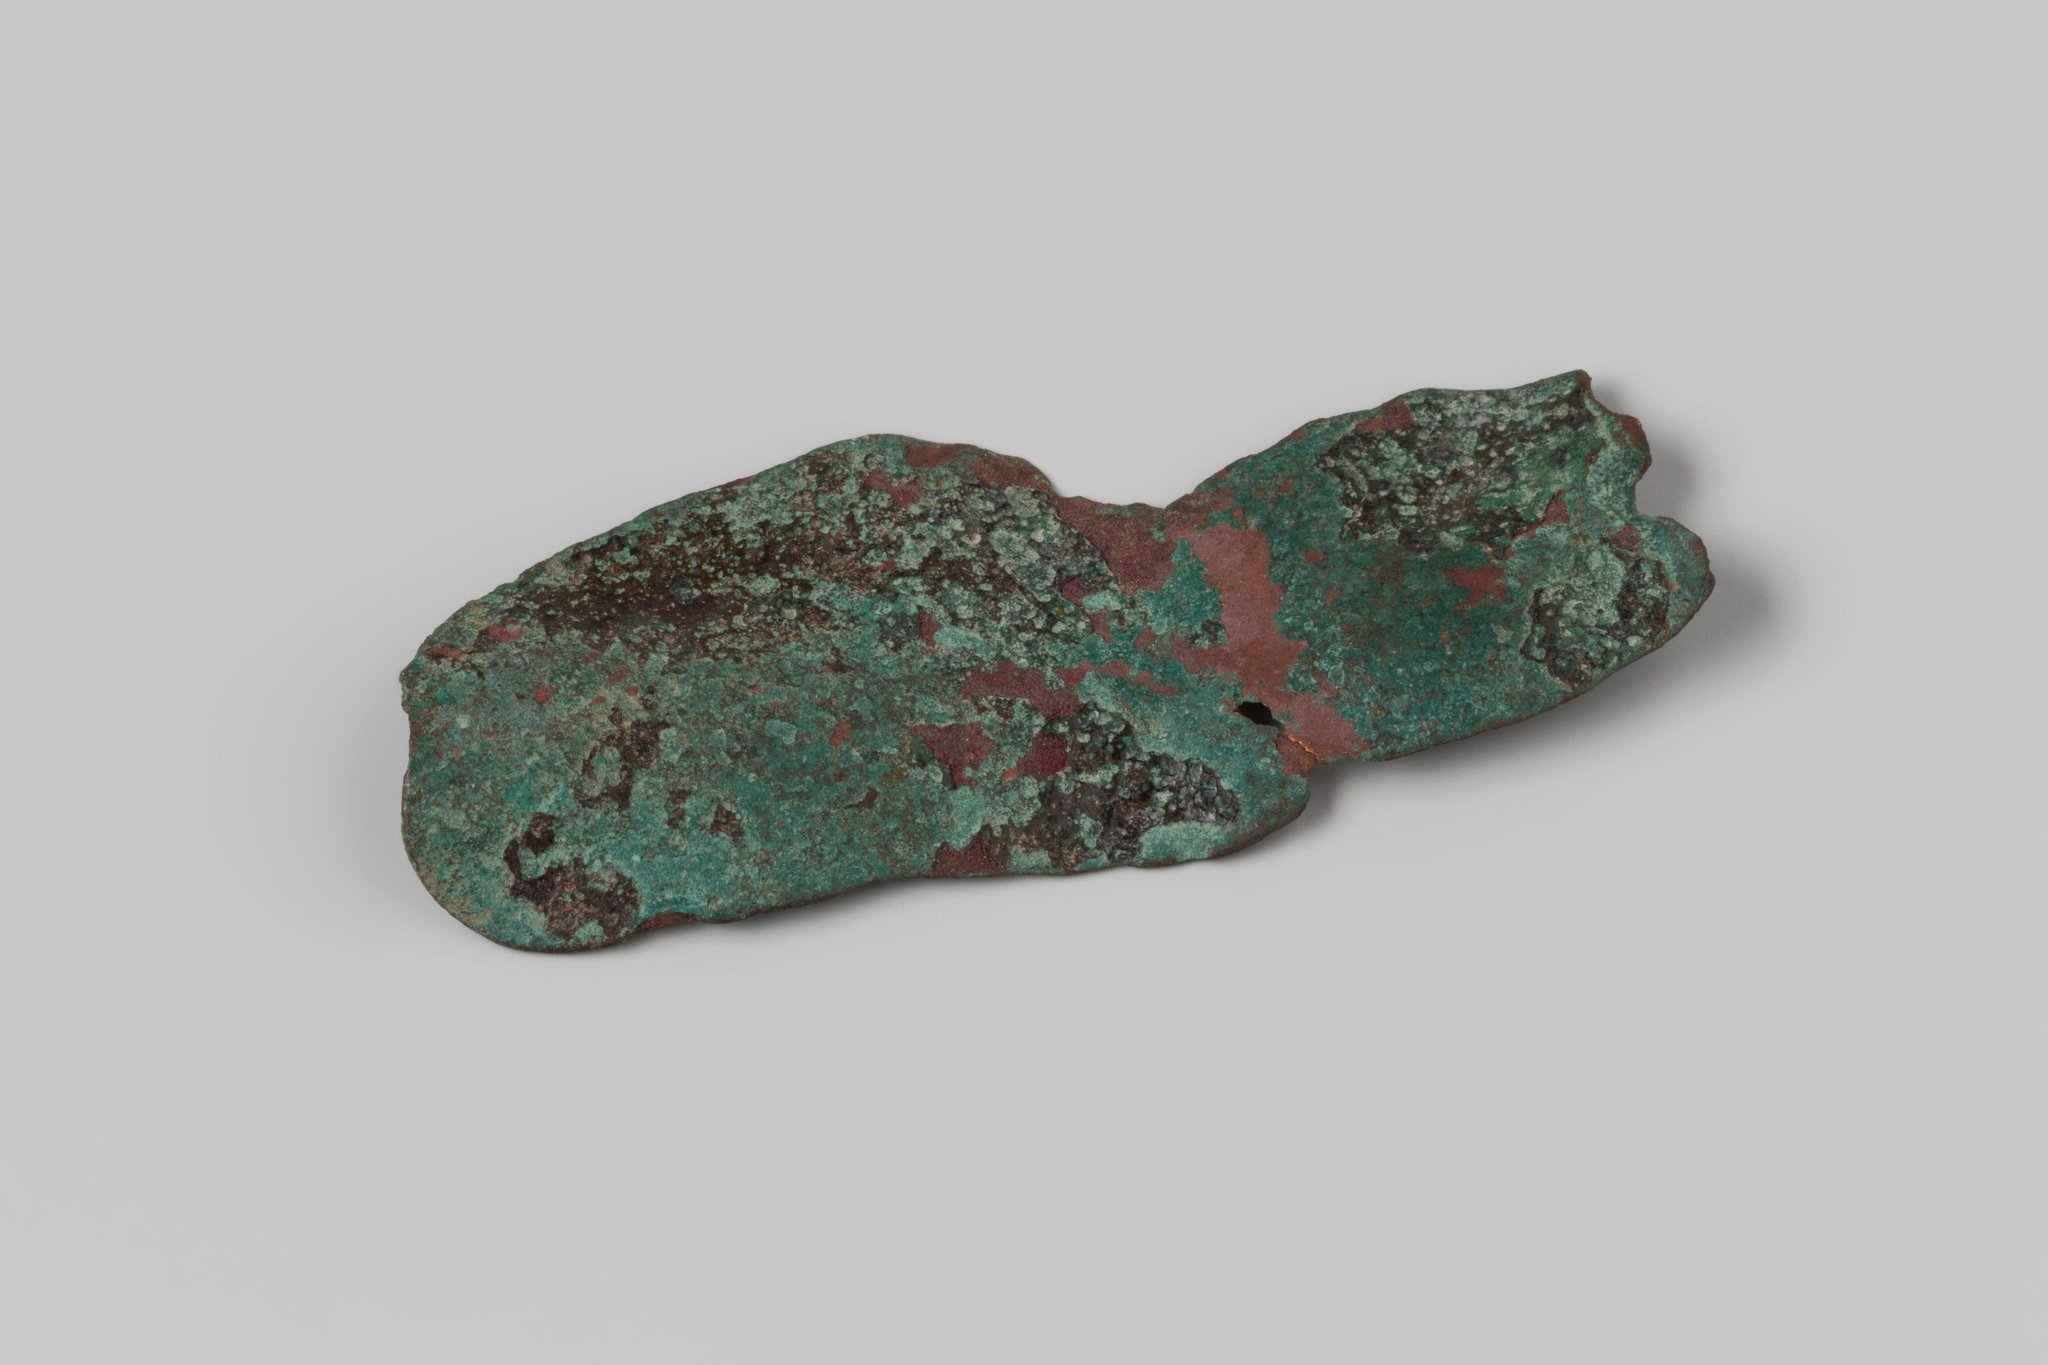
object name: scheepswrakvondst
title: Fragment van koper uit het wrak van de Oost-Indiëvaarder Hollandia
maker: Anonymous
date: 1700-1743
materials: copper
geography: netherlands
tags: verenigde oostindische compagnie, hollandia (schip), annet